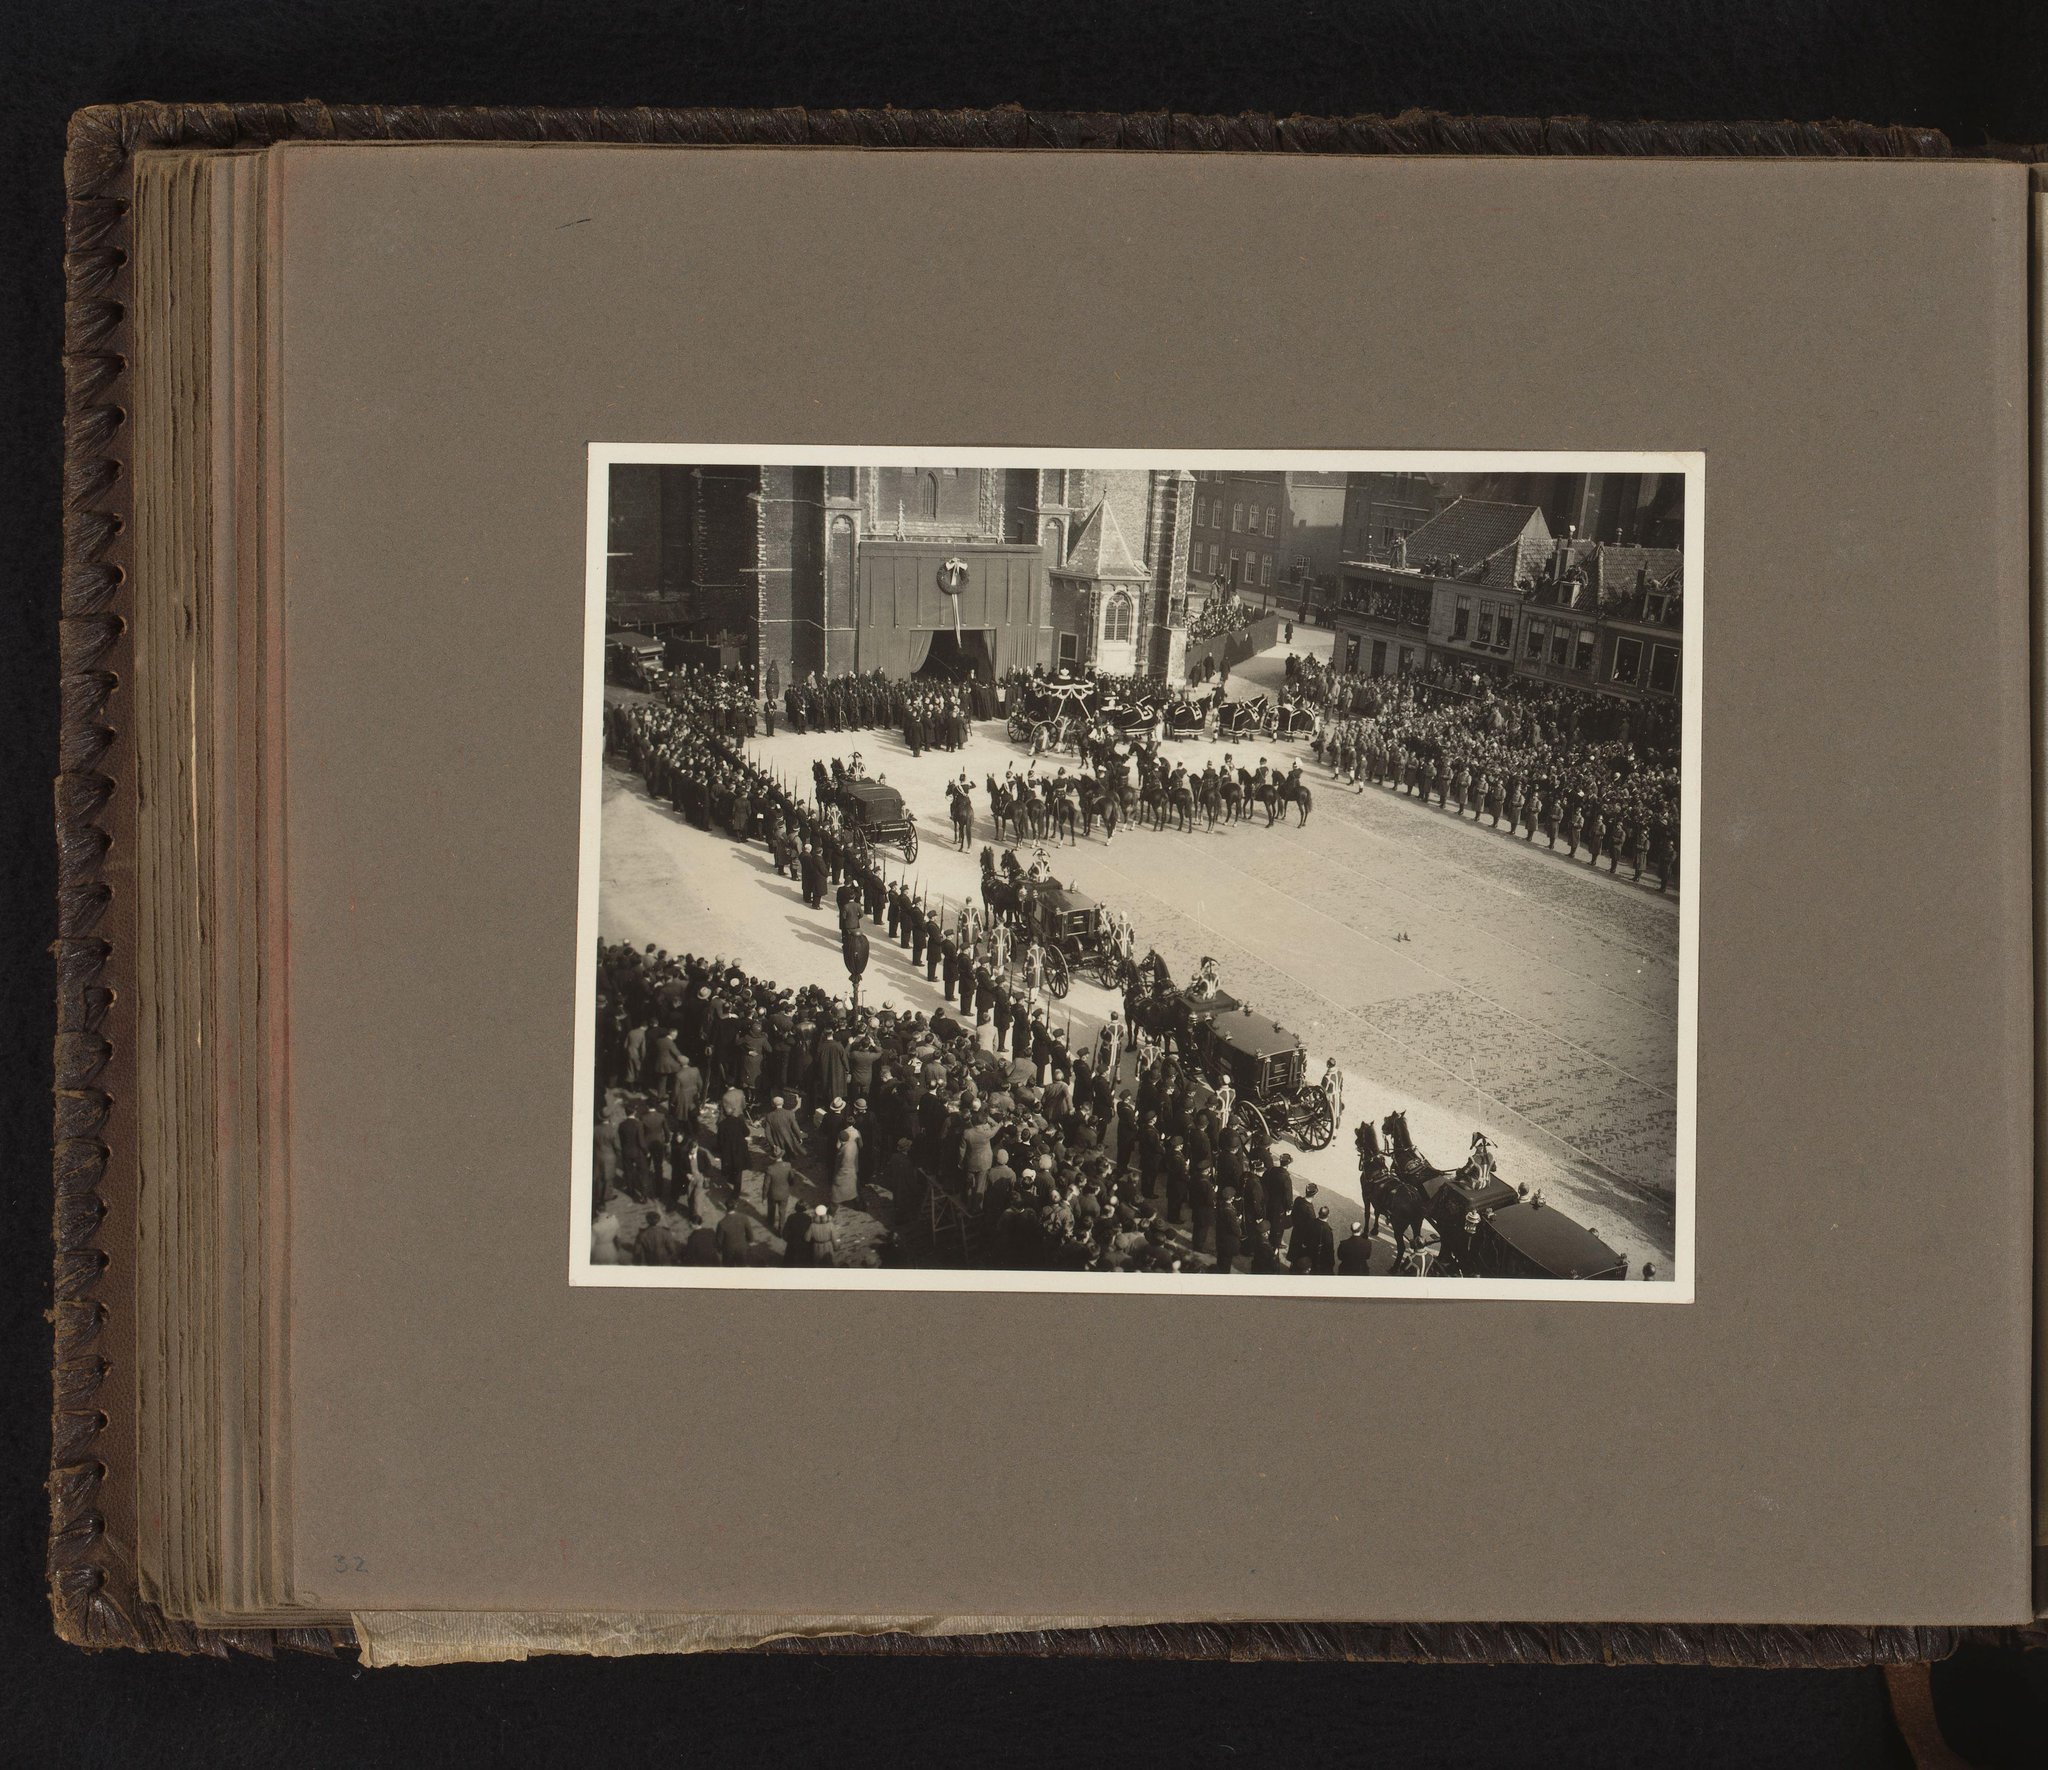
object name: album leaf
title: Koetsen, ruiters en mensen op de Markt te Delft voor de uitvaart van koningin-moeder Emma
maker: Anonymous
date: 1934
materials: paper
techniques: gelatin silver print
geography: delft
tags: the hague, emma (queen consort of the netherlands), public funeral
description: Deze foto's maken deel uit van een album.